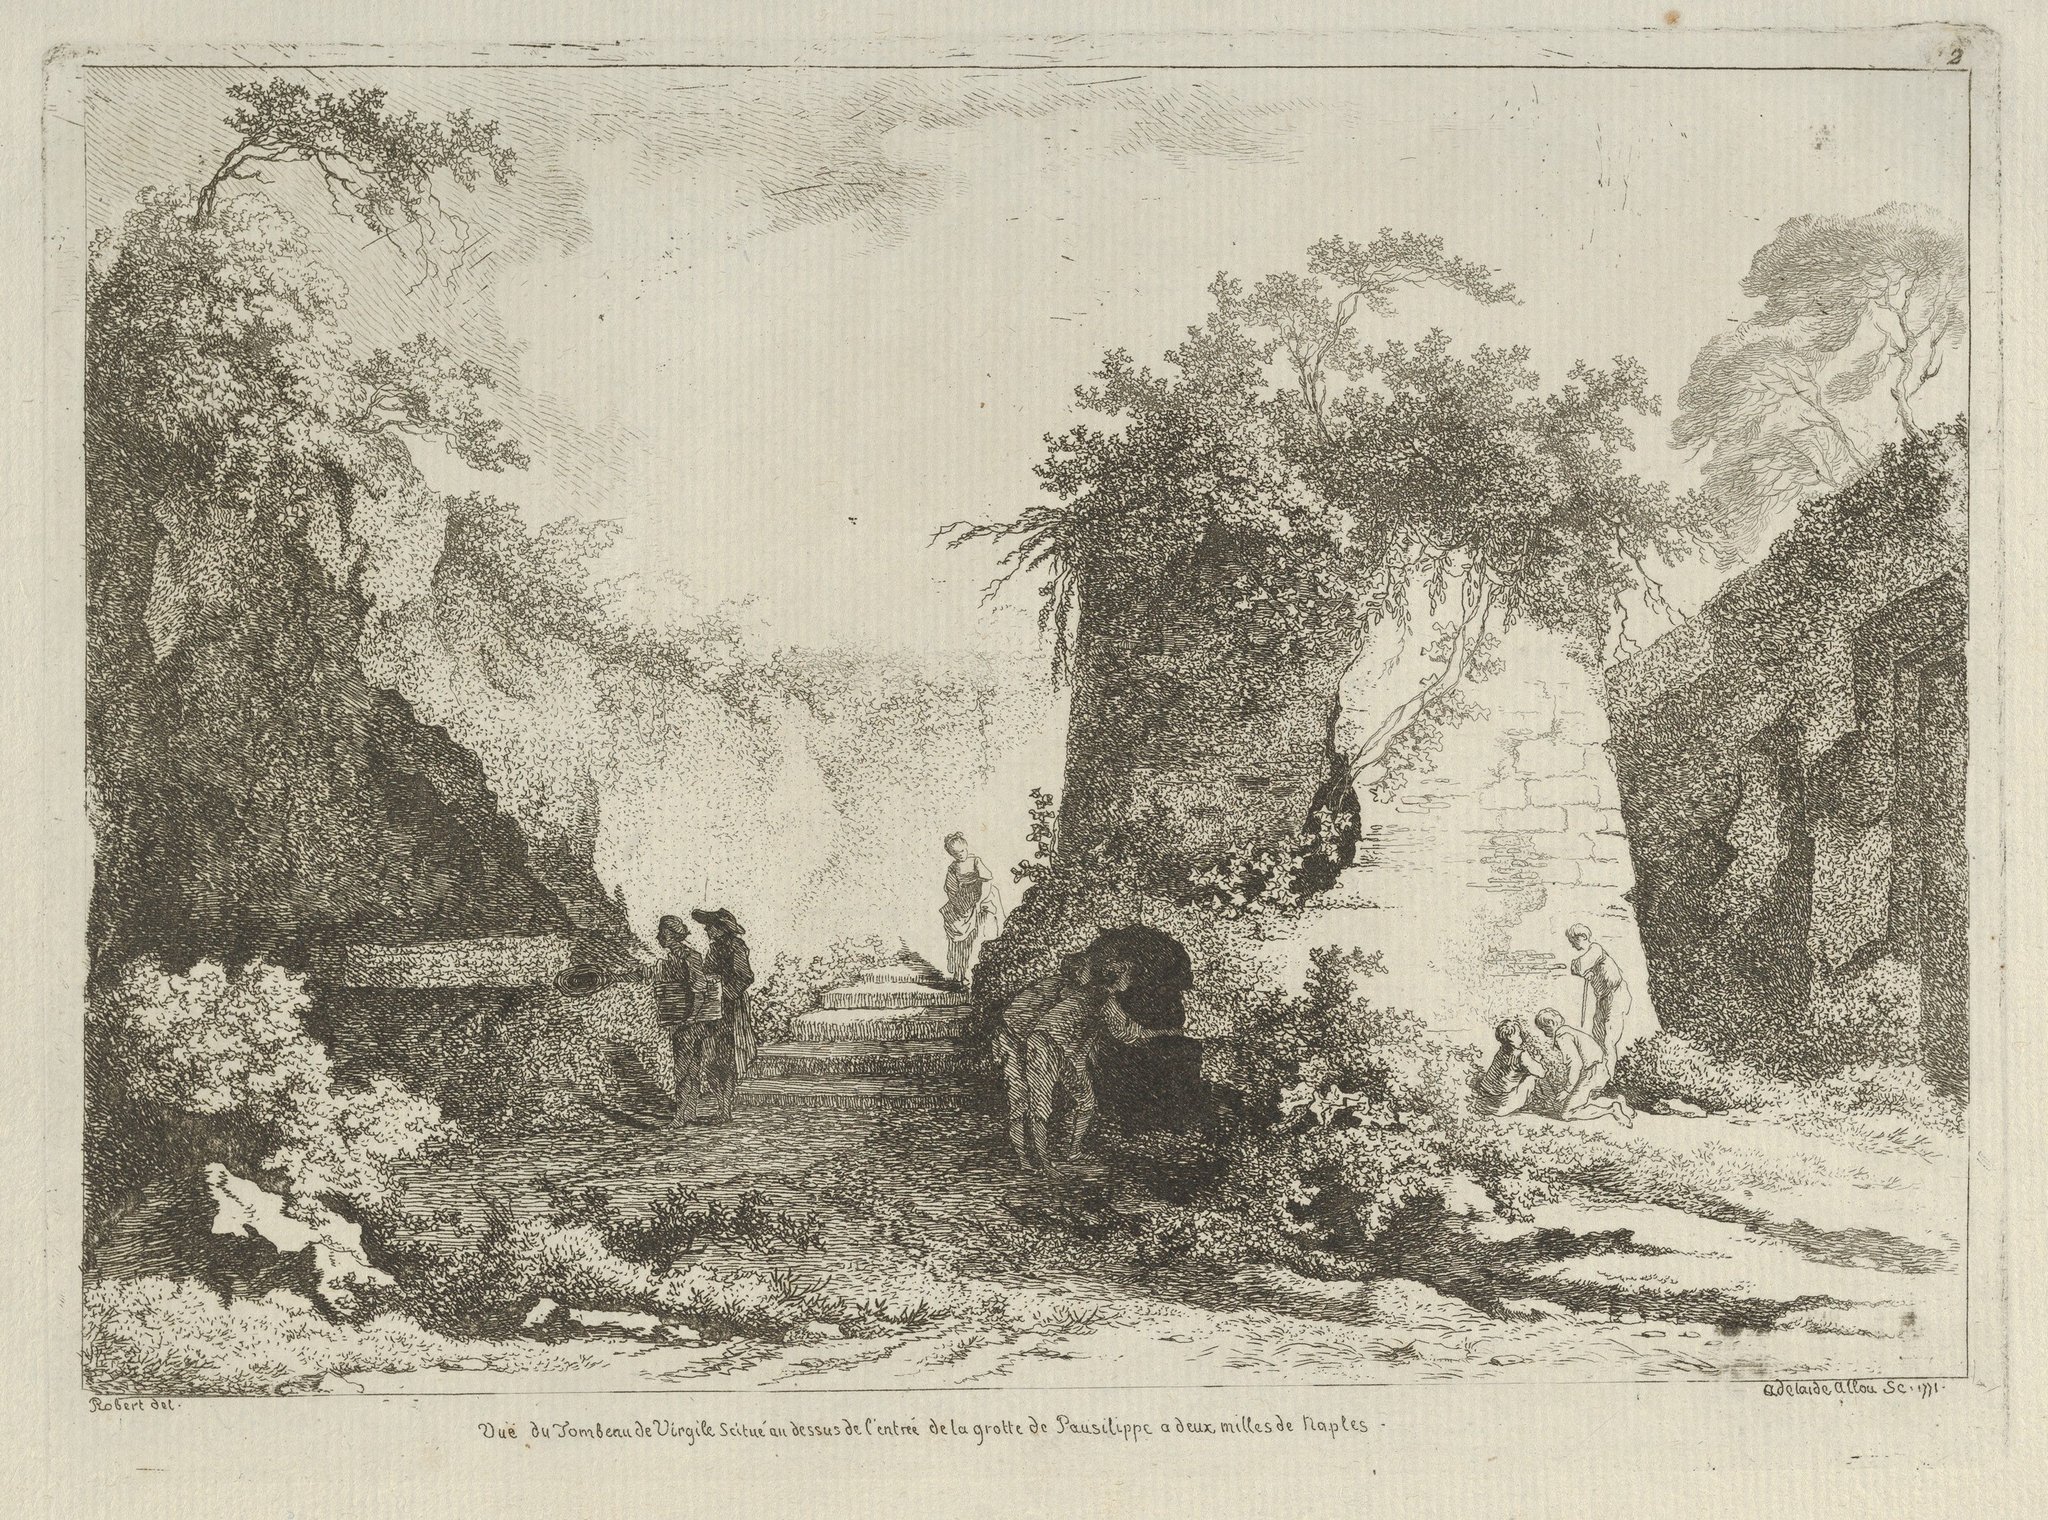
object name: print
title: Vue du Tombeau de Virgile from Differentes vues dessiné d'après nature... dans les environs de Rome et de Naples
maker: adélaide allou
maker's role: artist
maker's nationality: french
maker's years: 1776-1800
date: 1701-1800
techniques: etching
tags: human figures,tombs,landscapes